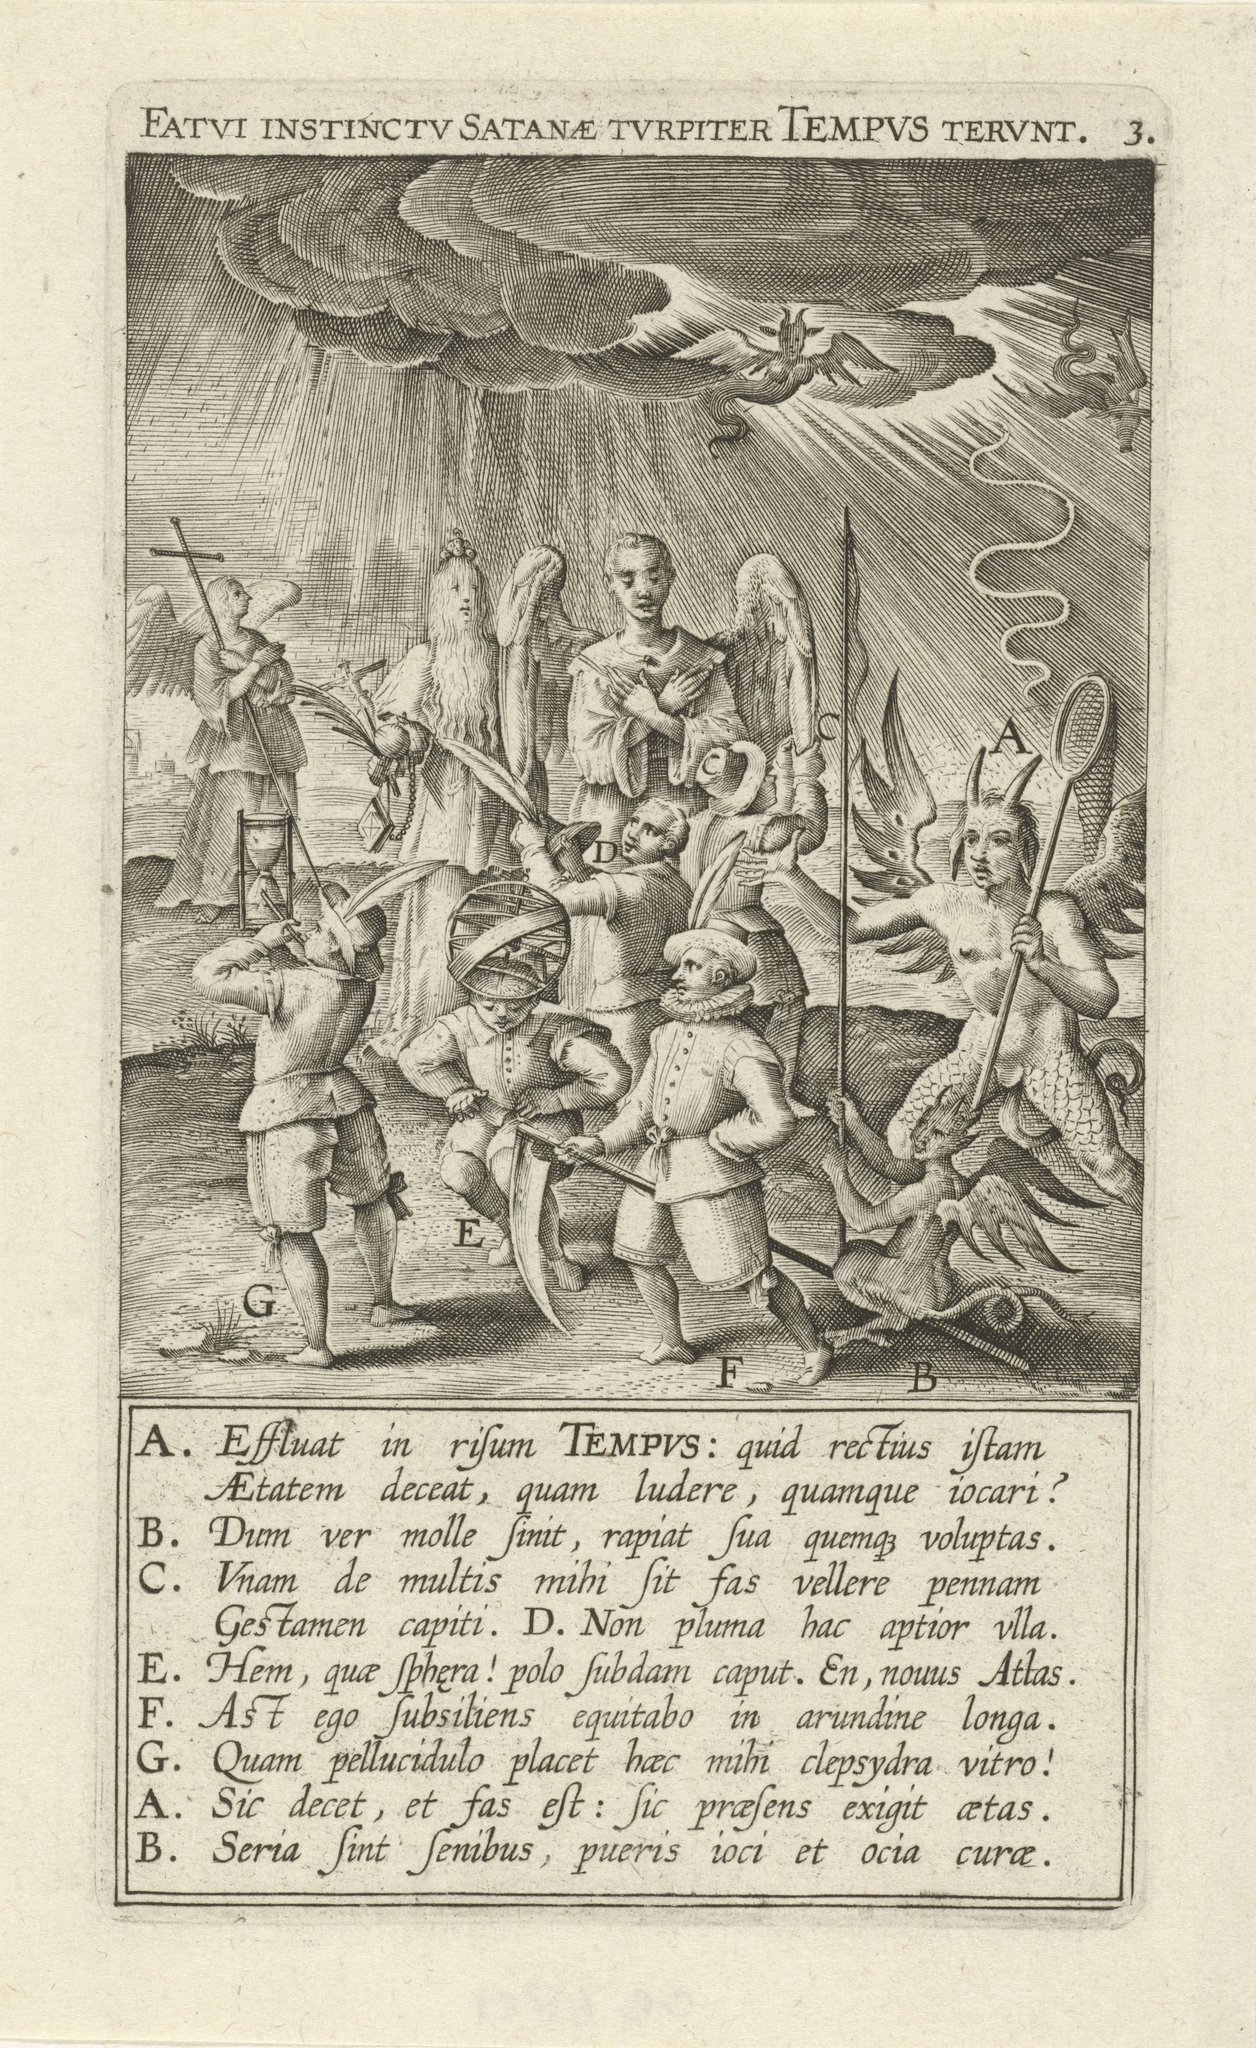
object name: print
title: Typus occasionis in quo receptae commoda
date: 1603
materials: paper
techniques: engraving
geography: antwerp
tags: 'occasio', 'kairos'; 'occasione' (ripa), children's games and plays, youth, adolescent, devil(s) appearing to mortals, trying to seduce them; temptation, other allegories of time, e.g. 'tempo' (ripa), angels, man as sinner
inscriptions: collector's mark: Lugt 2228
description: Zondige jongeren spelen, samen met duivels, met de attributen van Tijd: een globe, een zeis en een zandloper. De personificaties Tijd en Kans staan werkloos aan de kant. Op de achtergrond de engel van het Geloof. De prent heeft een Latijns onderschrift met legende en maakt deel uit van een 12-delige serie over het benutten van kansen.